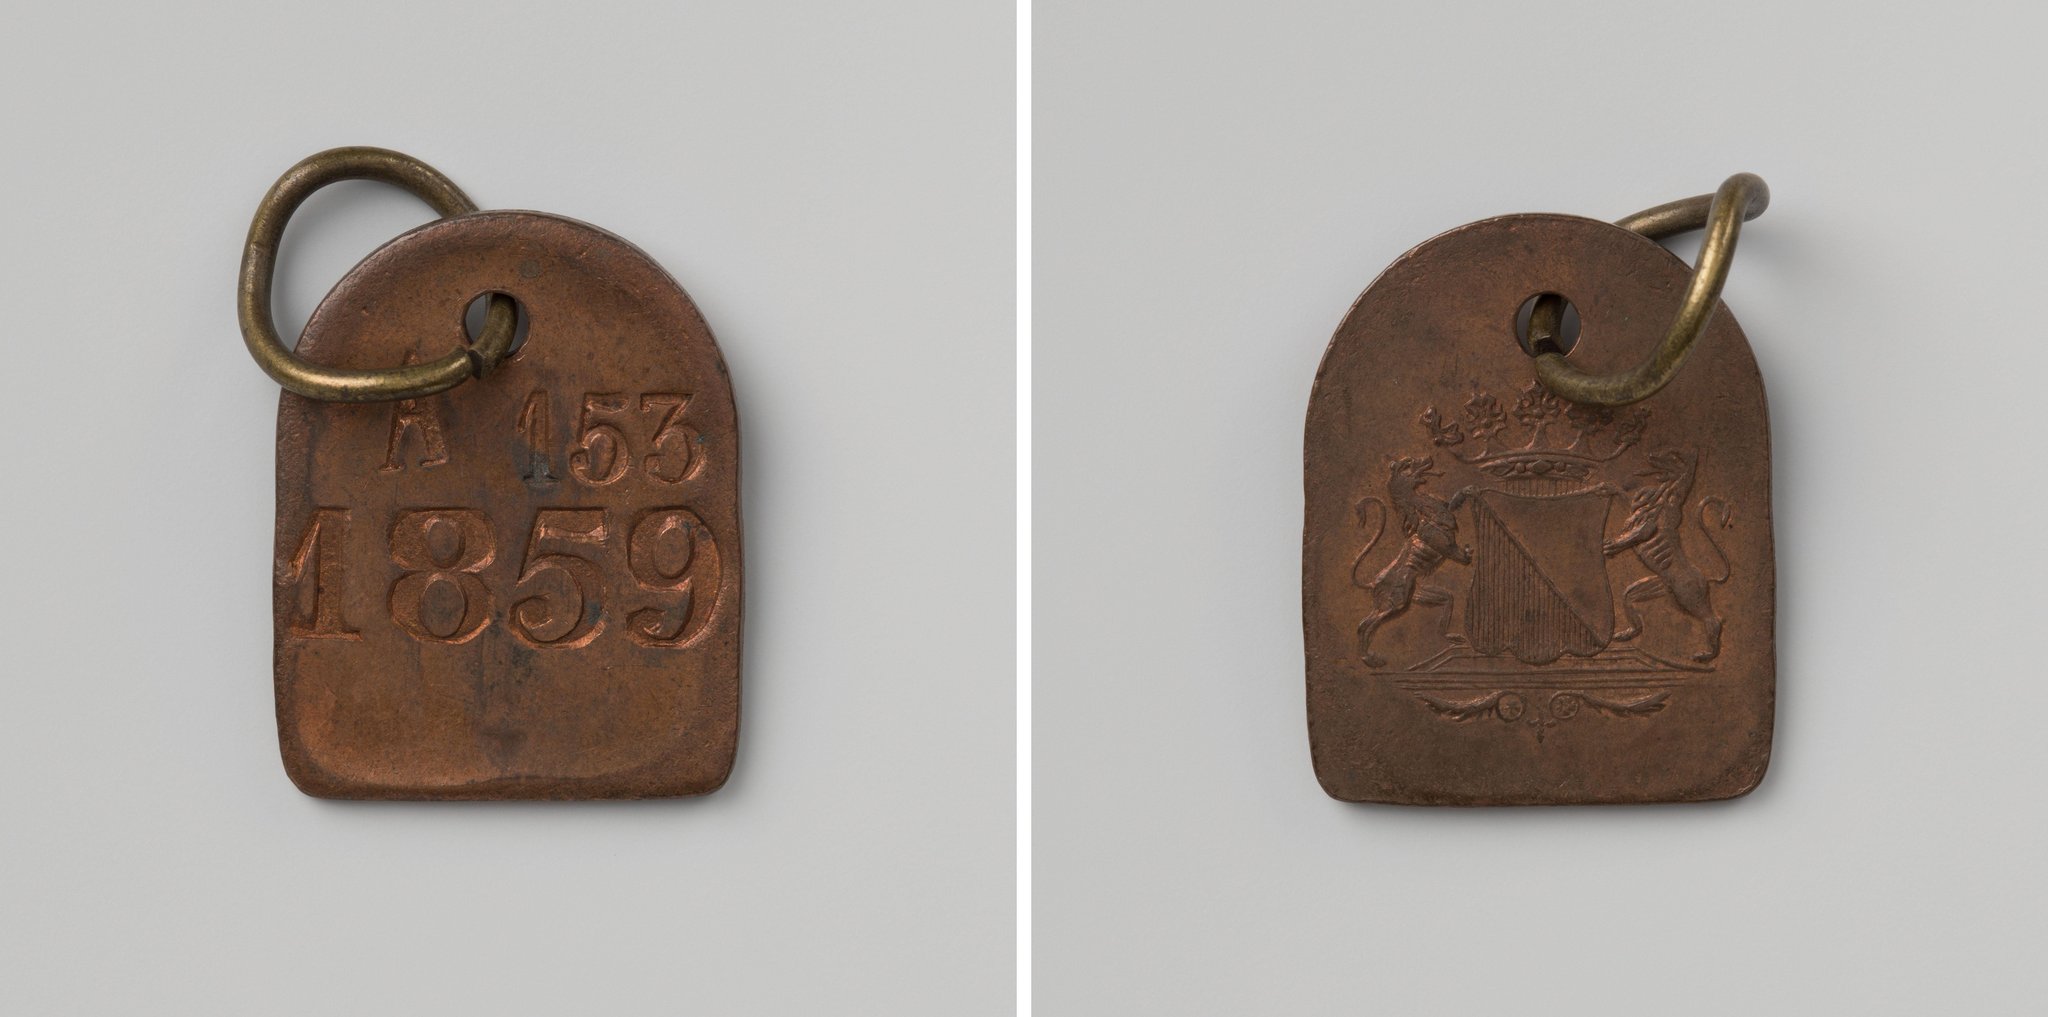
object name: hondenbelastingloodje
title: Stad Utrecht, loodje met letter A en no. 153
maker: Anonymous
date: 1859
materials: copper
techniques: striking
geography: utrecht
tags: utrecht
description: rechthoekig loodje met aan bovenzijde ronde hoeken en gat erin aan draagring. Voorzijde: letter A en cijfer 153 boven jaartal. Keerzijde: gekroond wapenschild, geflankeerd door twee leeuwen